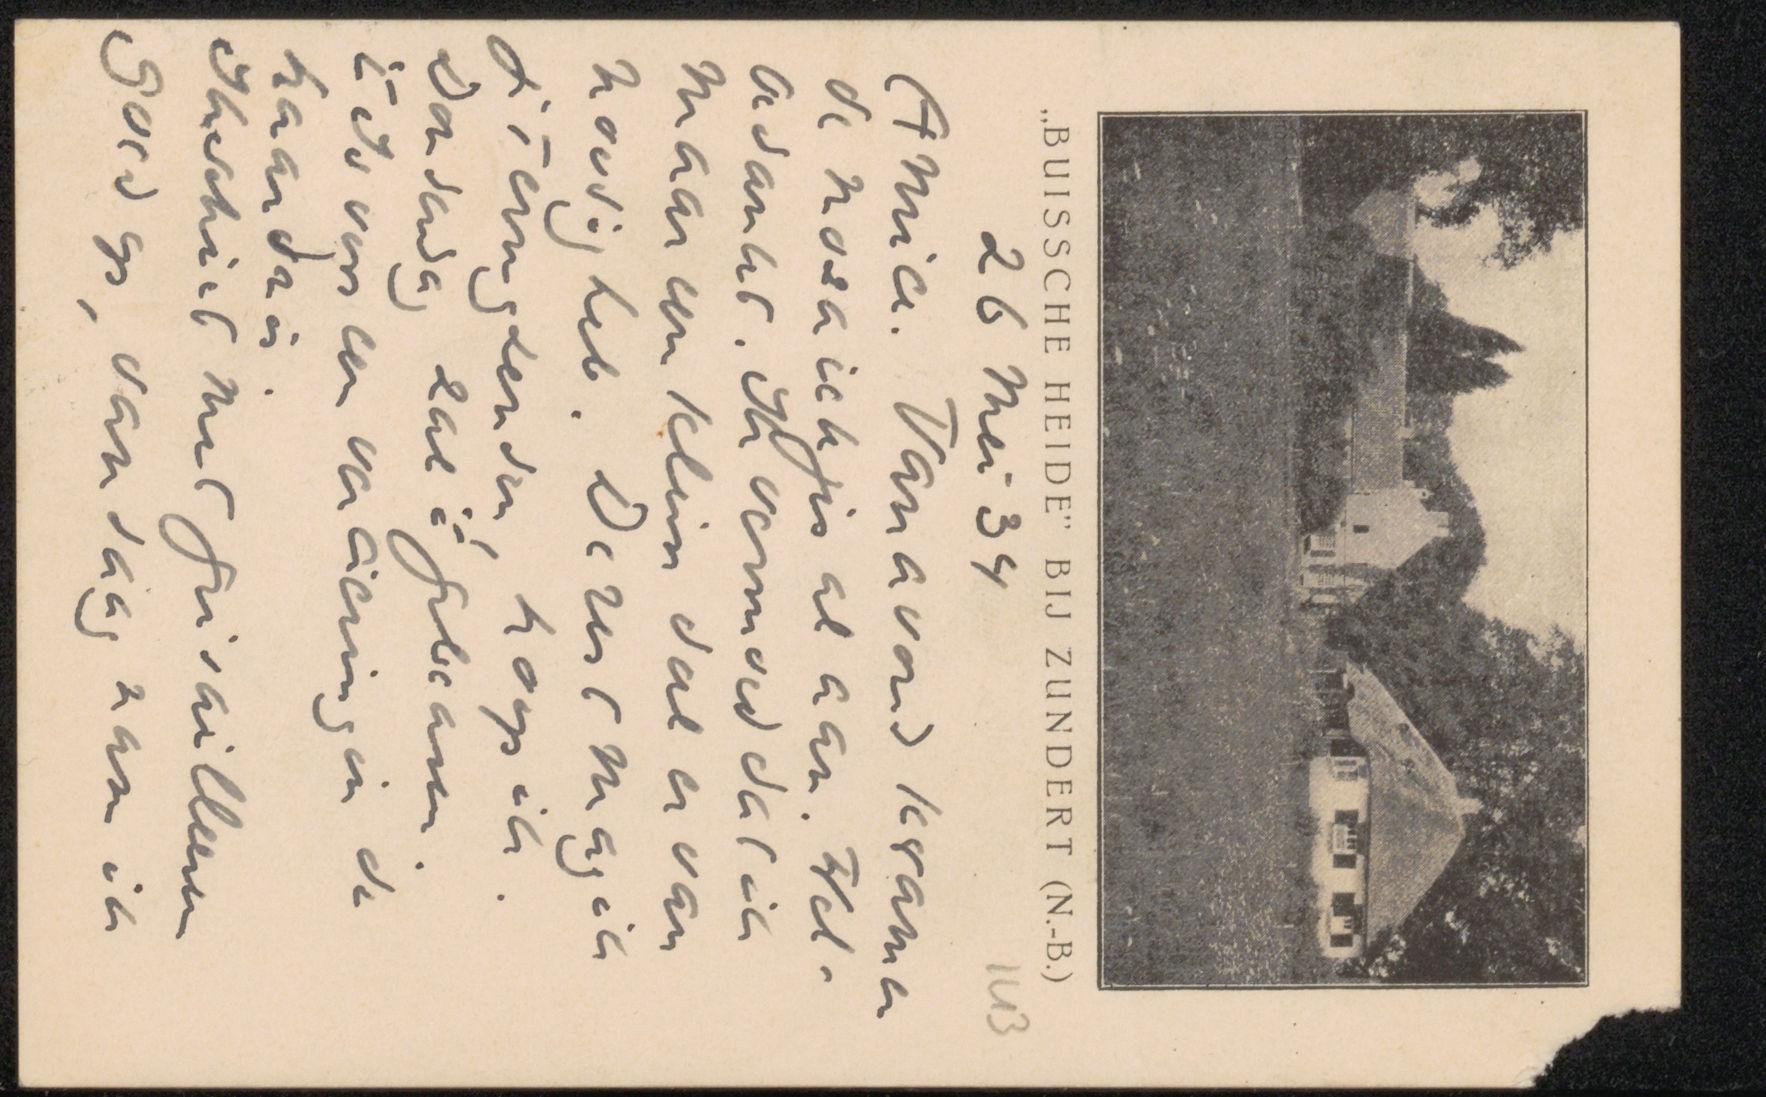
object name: ansichtkaart, prentbriefkaart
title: Prentbriefkaart aan Willem Bogtman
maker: richard nicolaüs roland holst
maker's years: 1868-1938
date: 1934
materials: cardboard, ink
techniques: pen, writing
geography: buissche heide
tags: willem bogtman, applied arts, arts and crafts; industrial design